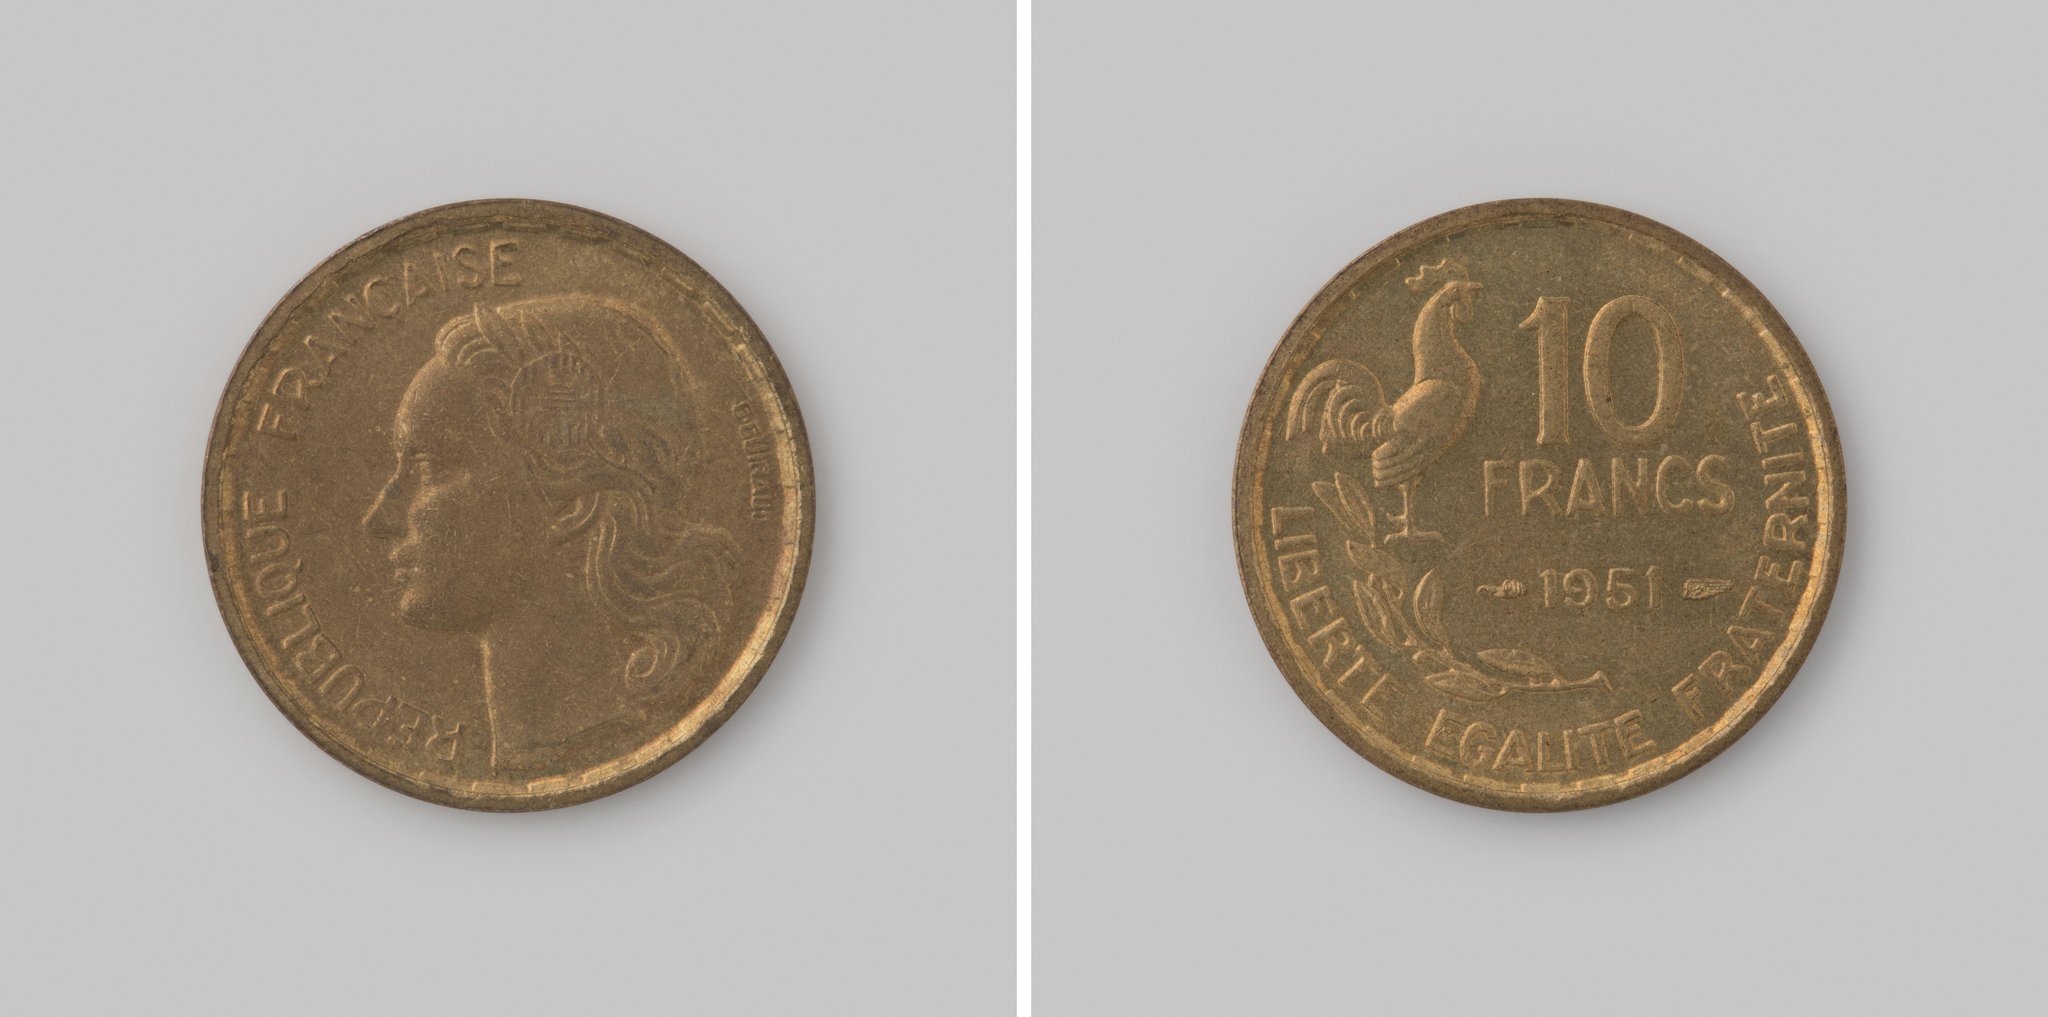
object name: coin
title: Frankrijk, 10 francs, 1951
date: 1951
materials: bronze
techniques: striking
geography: paris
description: Aluminium-bronzen munt. Voorzijde: hoofd van een vrouw met krans in het haar naar links. Keerzijde: haan naar rechts, waaronder tak. Rechts daarvan waarde-aanduiding in twee regels, waaronder jaartal. Gladde rand.